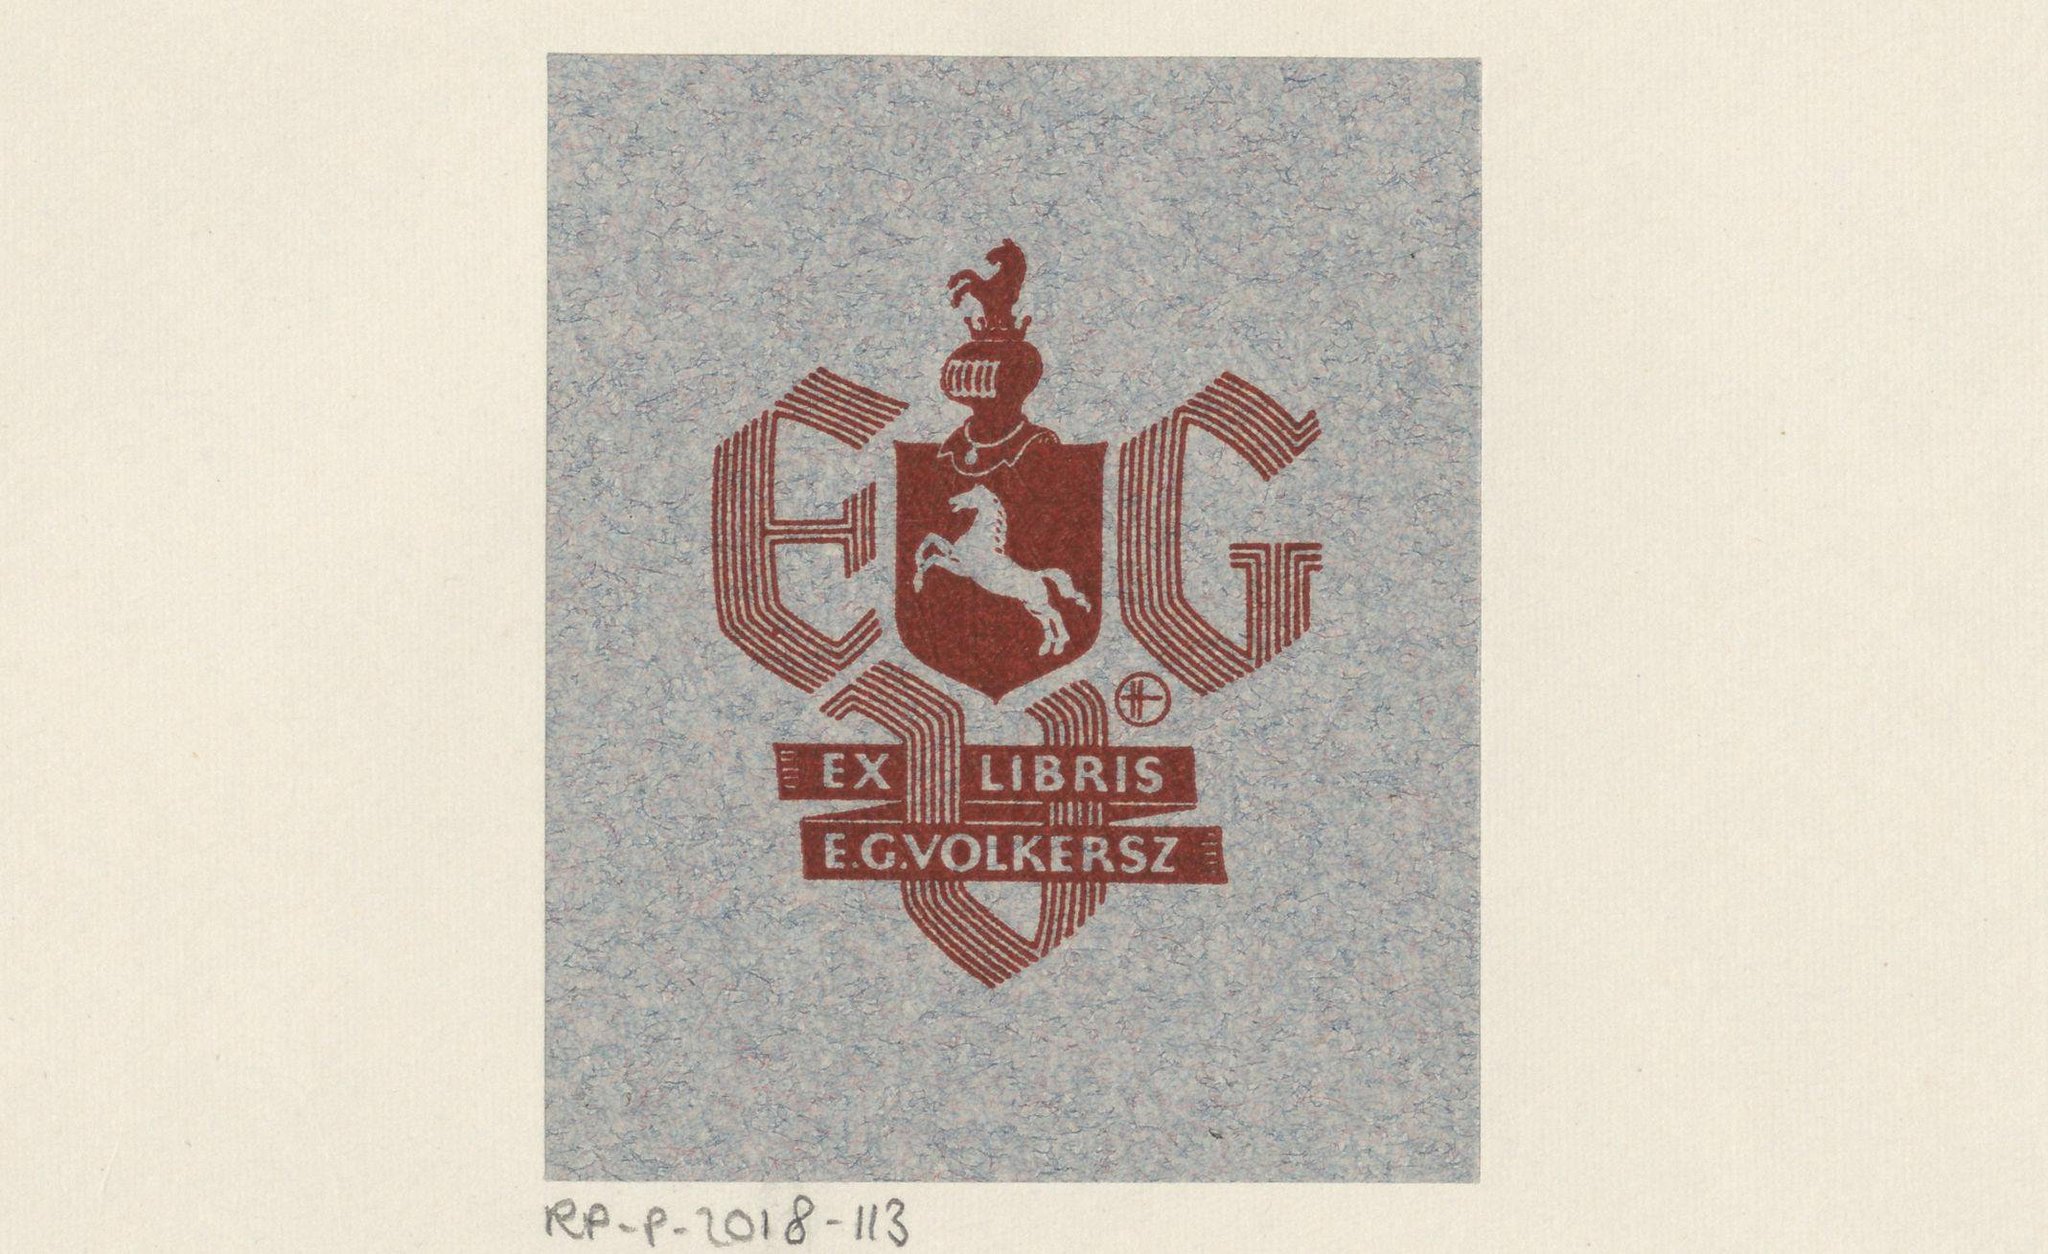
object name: bookplate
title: Ex libris van E.G. Volkersz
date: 1935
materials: paper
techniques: printing block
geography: austria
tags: horse, armorial bearing, heraldry